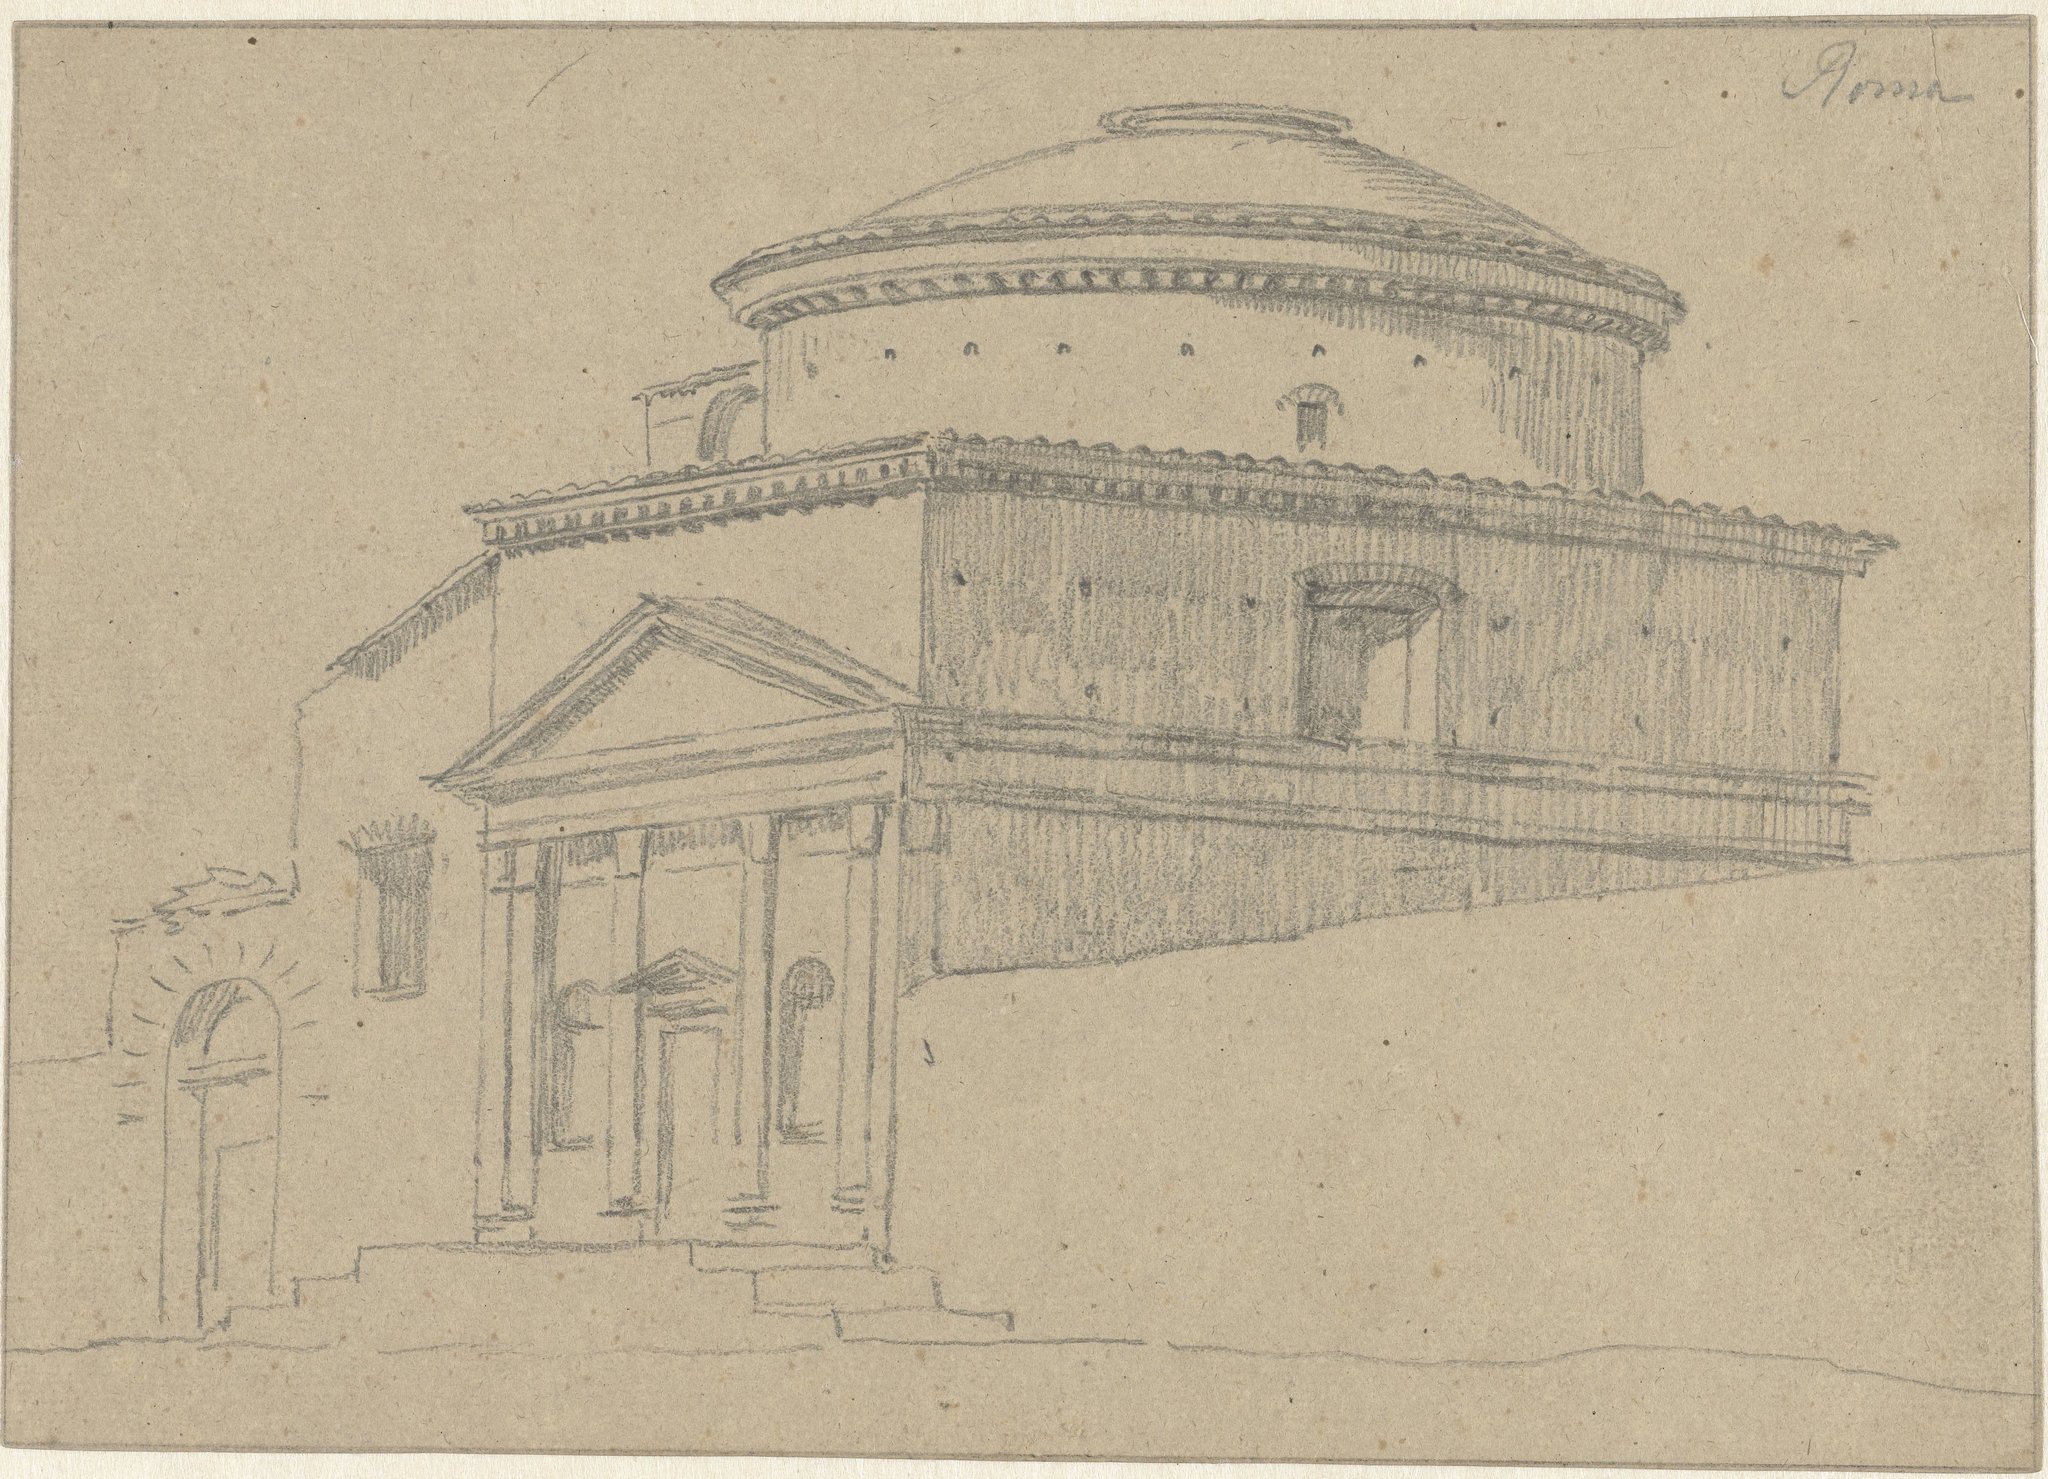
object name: drawing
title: De kerk Sant'Andrea in Via Flaminia, Rome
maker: hendrik voogd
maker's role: draughtsman, painter, print maker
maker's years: 1768-1839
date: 1788-1839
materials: paper, pencil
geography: rome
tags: church (exterior), rome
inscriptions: inscription: ‘Roma’